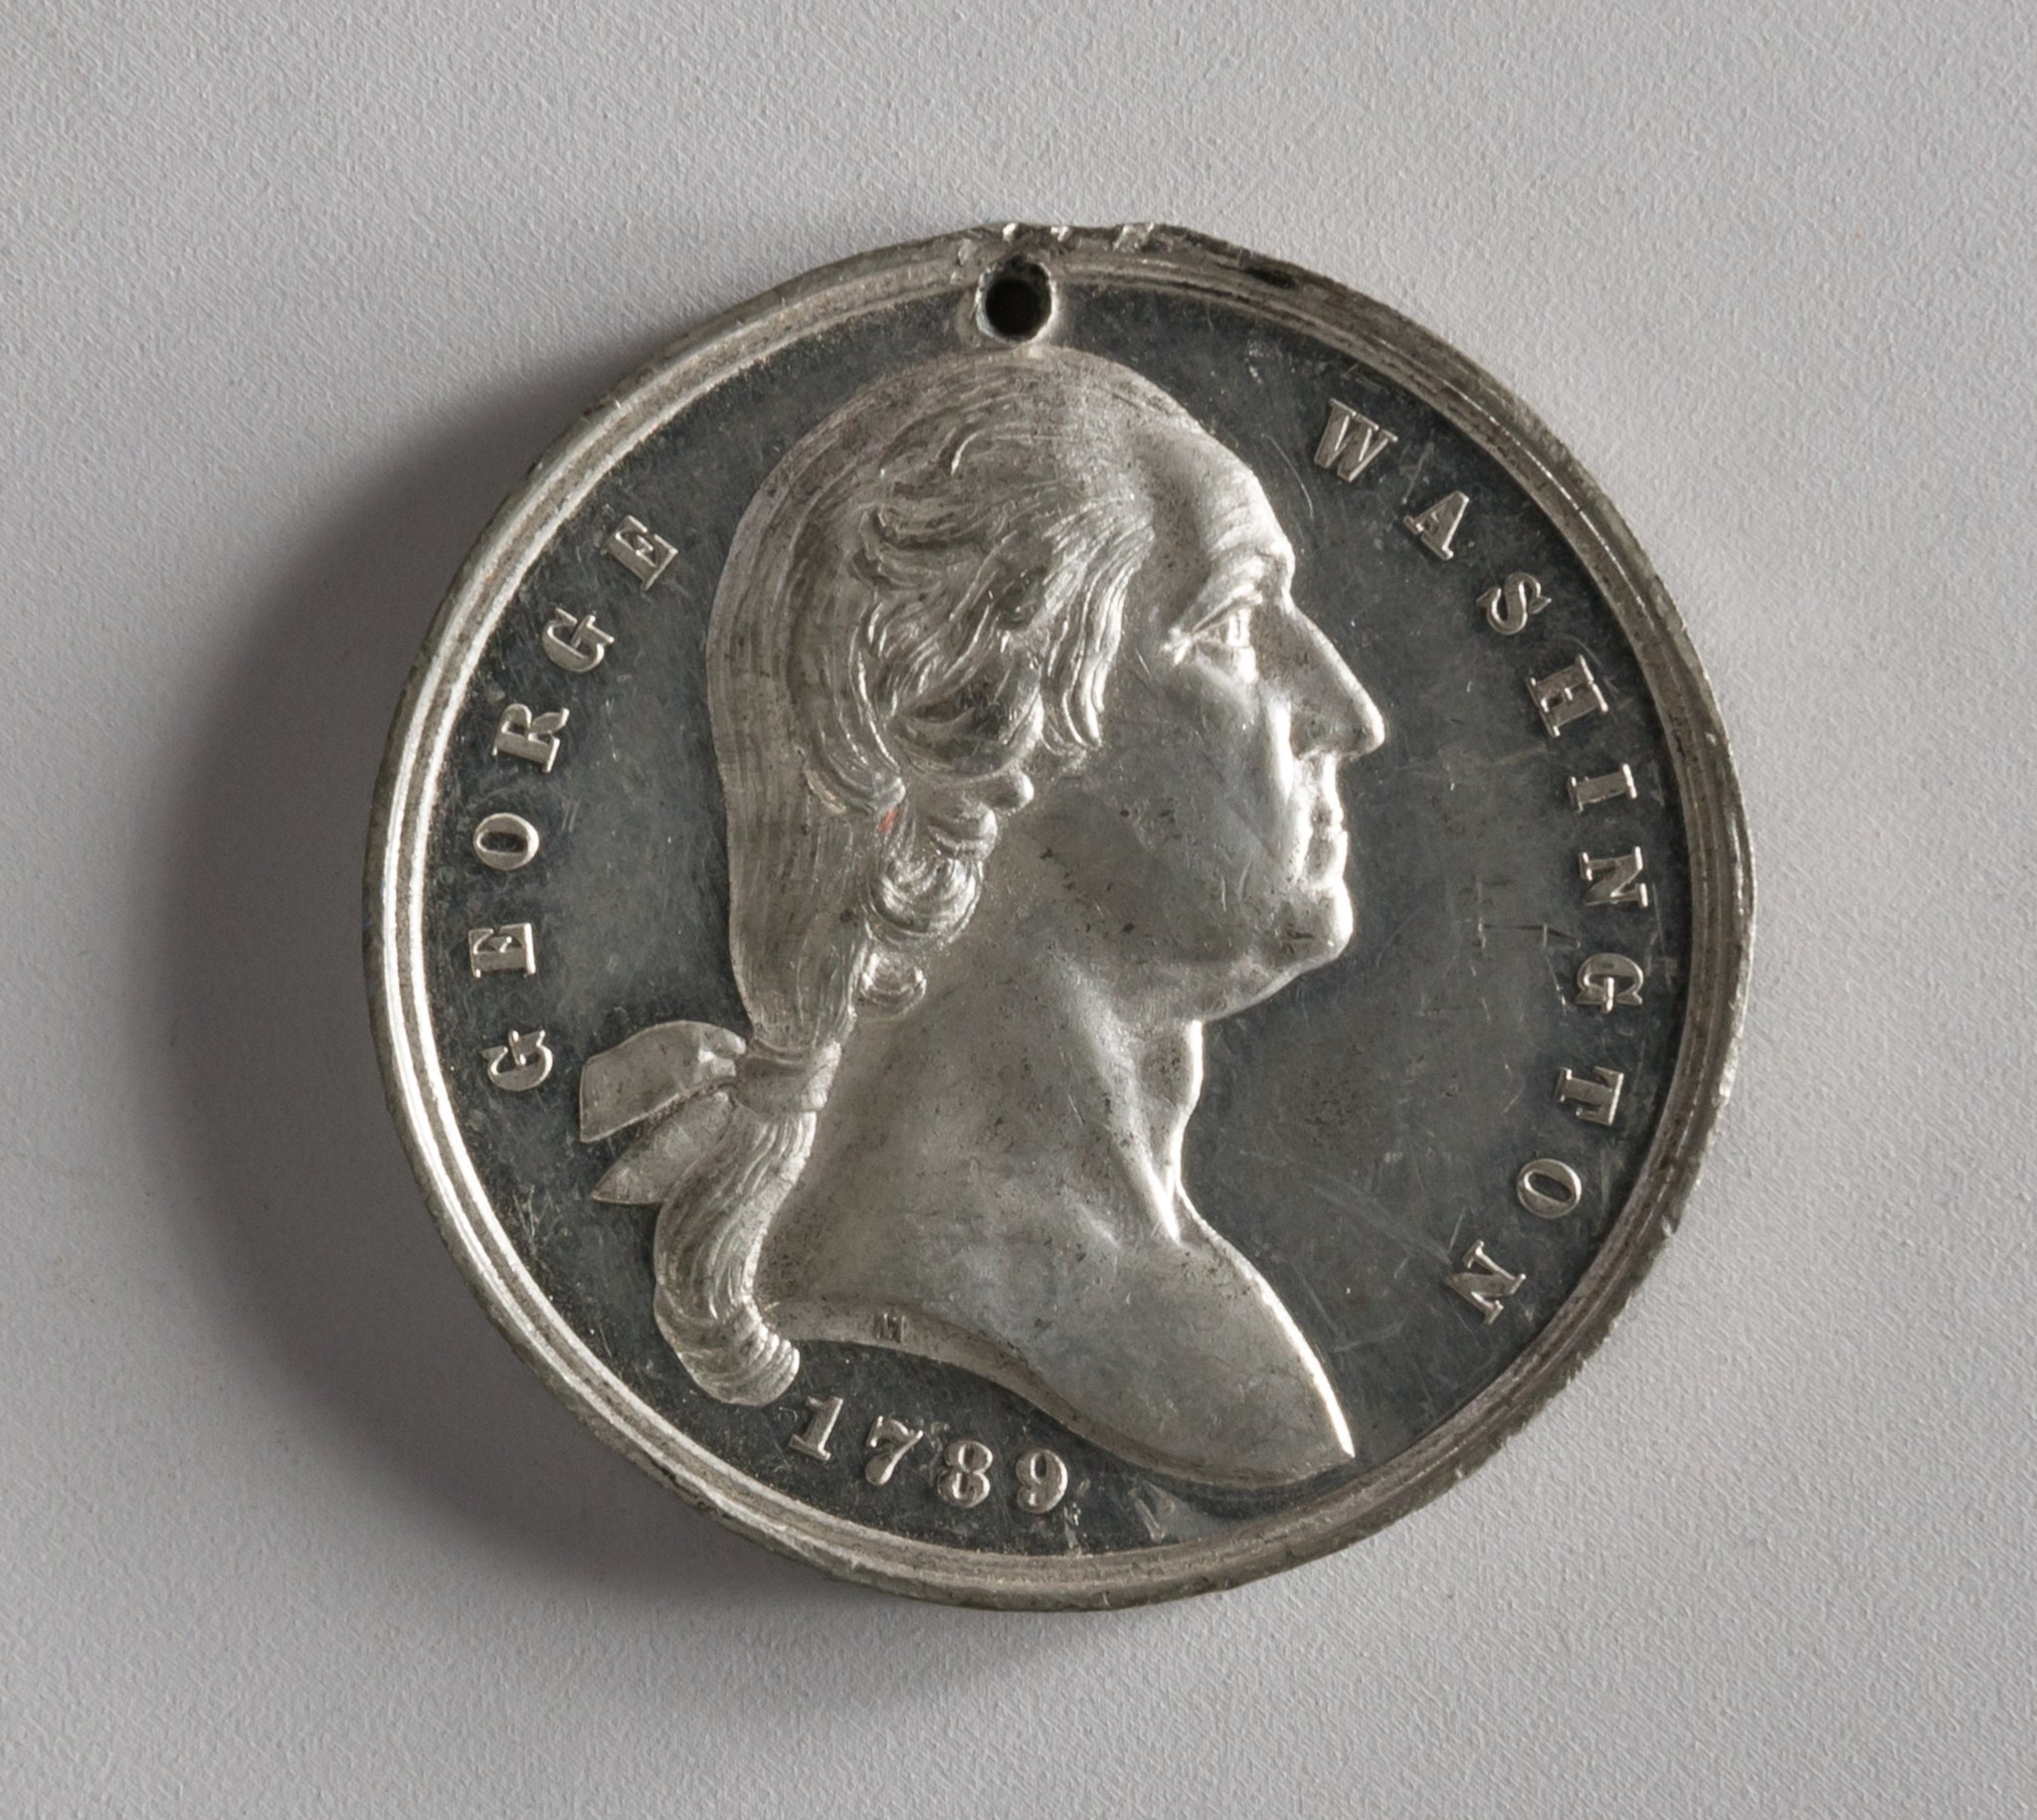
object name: medal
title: Centennial of Washington's Inauguration, 1889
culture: american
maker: joseph h. merriam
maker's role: artist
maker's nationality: american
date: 1889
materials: metal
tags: george washington,profiles